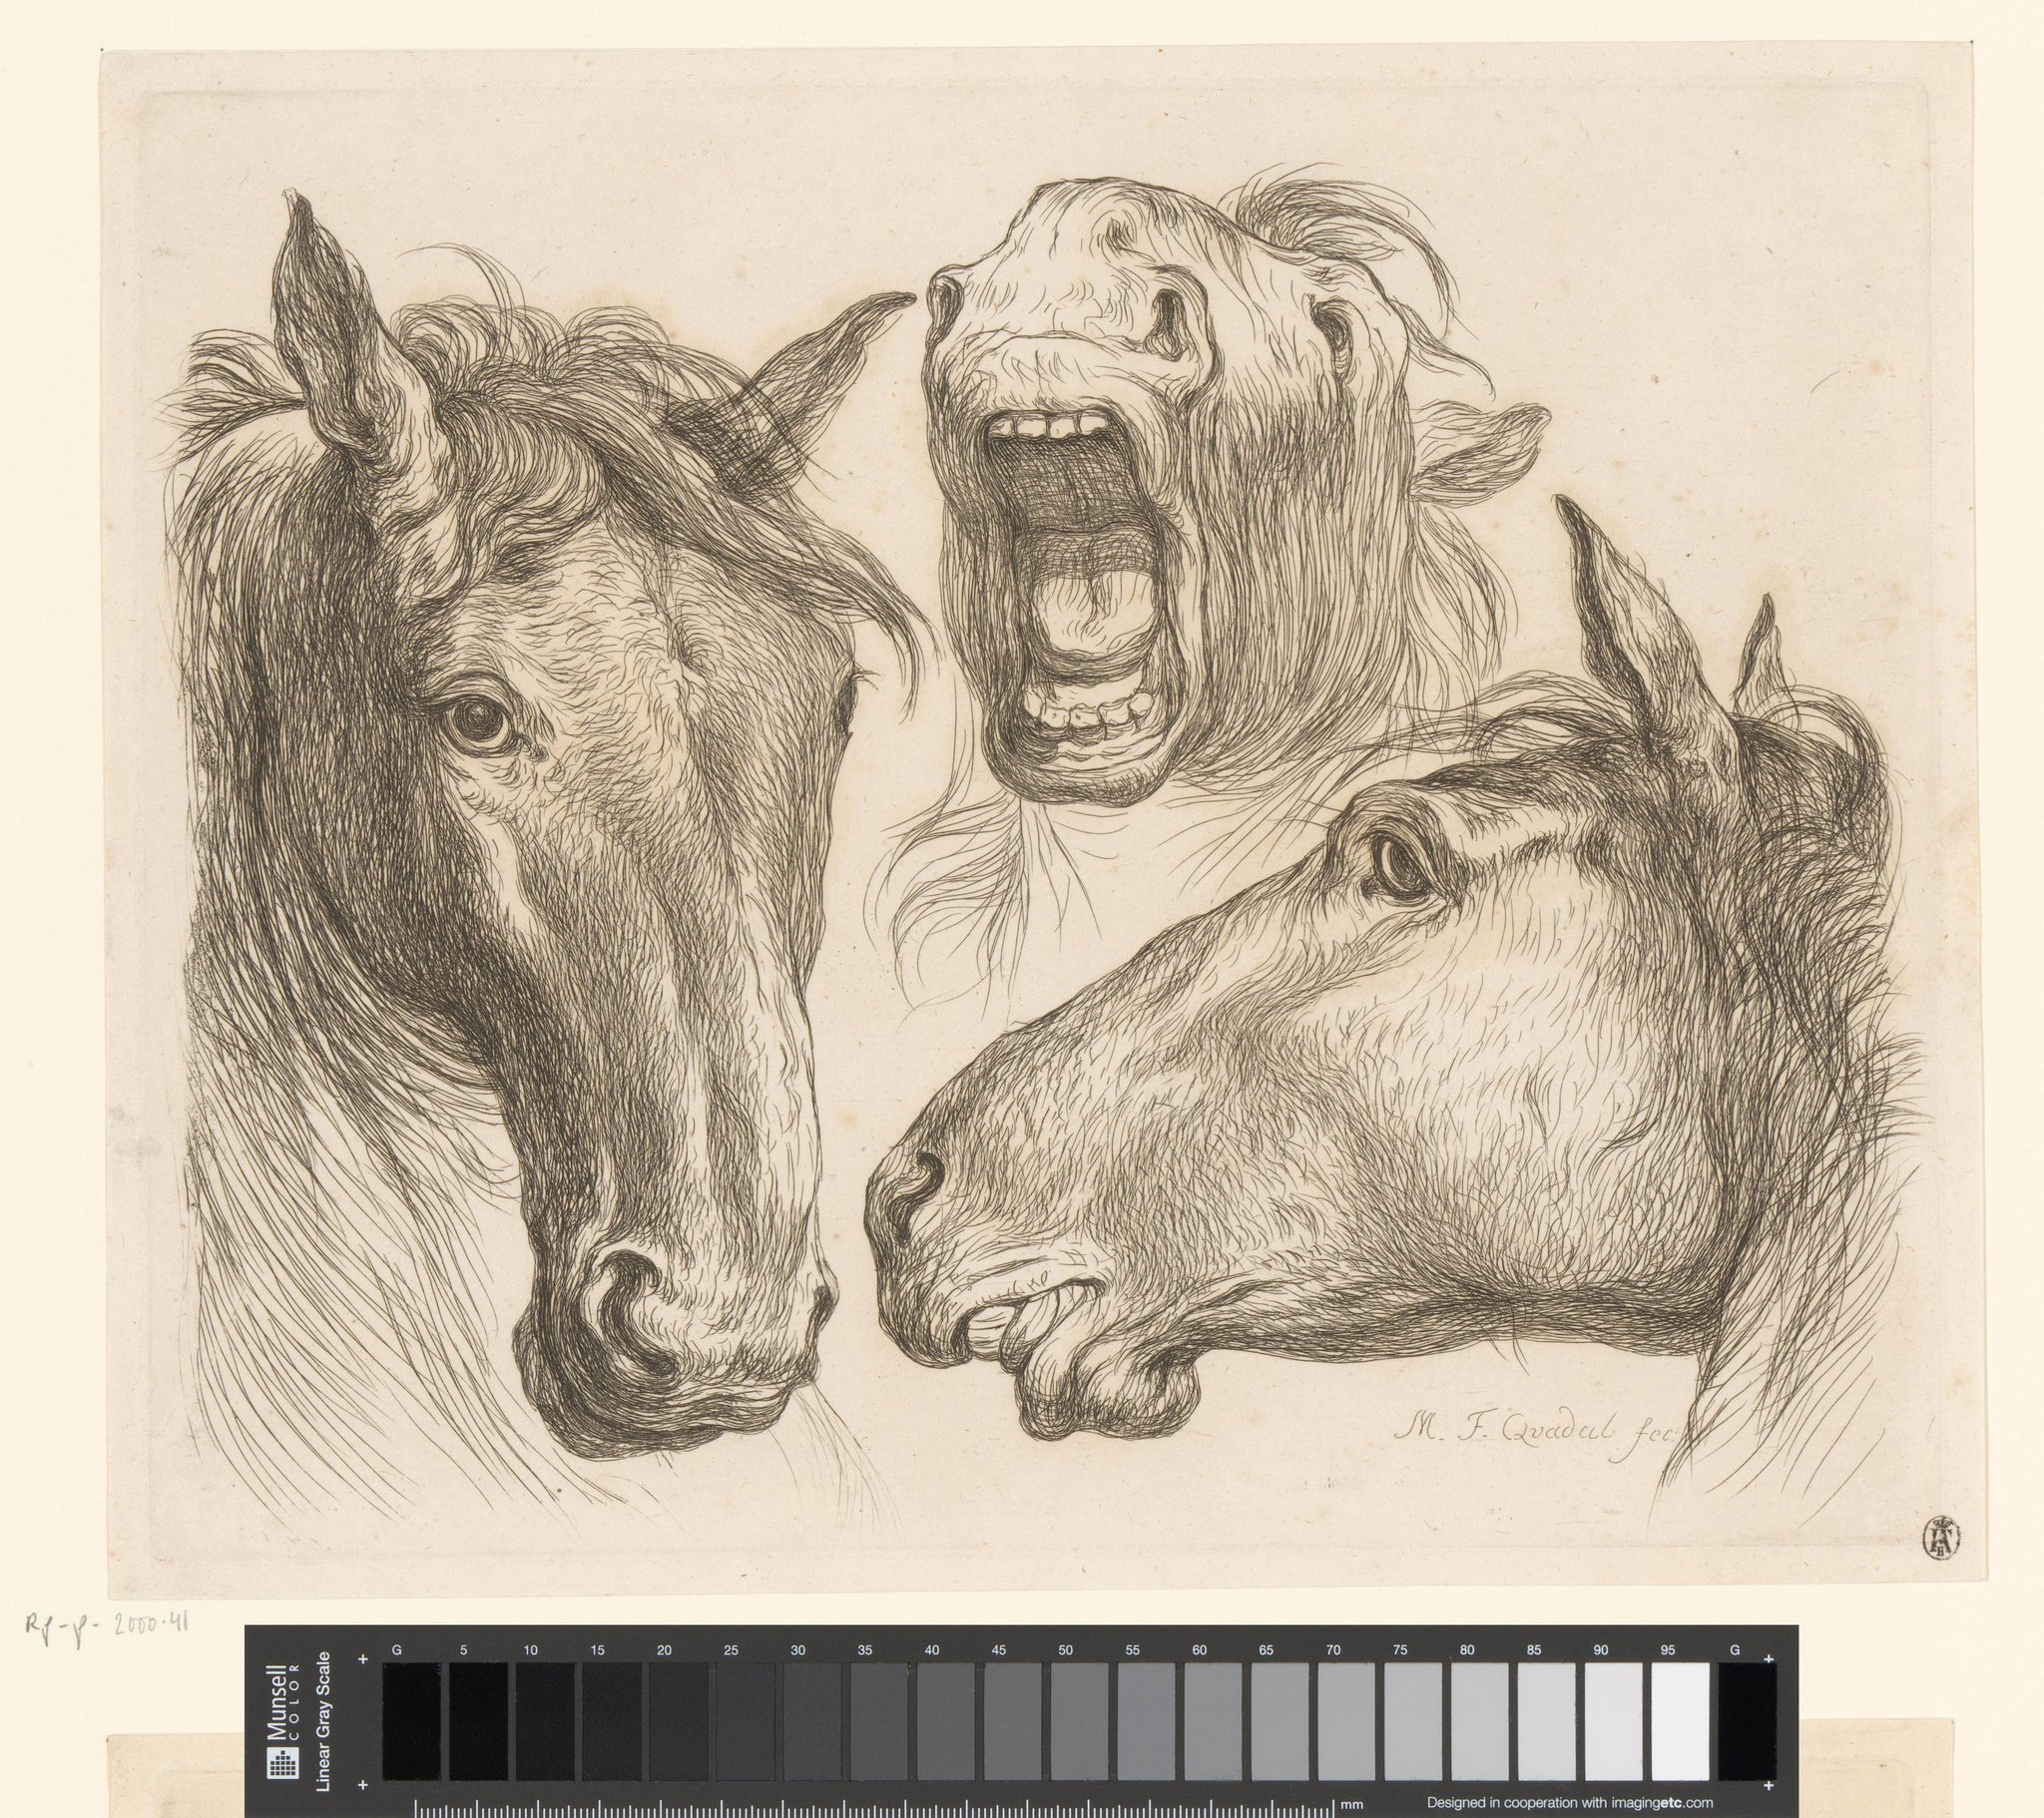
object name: print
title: Drie paardenhoofden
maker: martin ferdinand quadal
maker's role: print maker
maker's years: 1736-1808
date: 1793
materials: paper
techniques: etching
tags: horse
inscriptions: collector's mark: Lugt 2228, collector's mark: Lugt 2760, collector's mark: Lugt 971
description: Prent onderdeel van de serie: A variety of Tame and Wild Animals Studies from nature (...). Londen: Quadal, 1793.